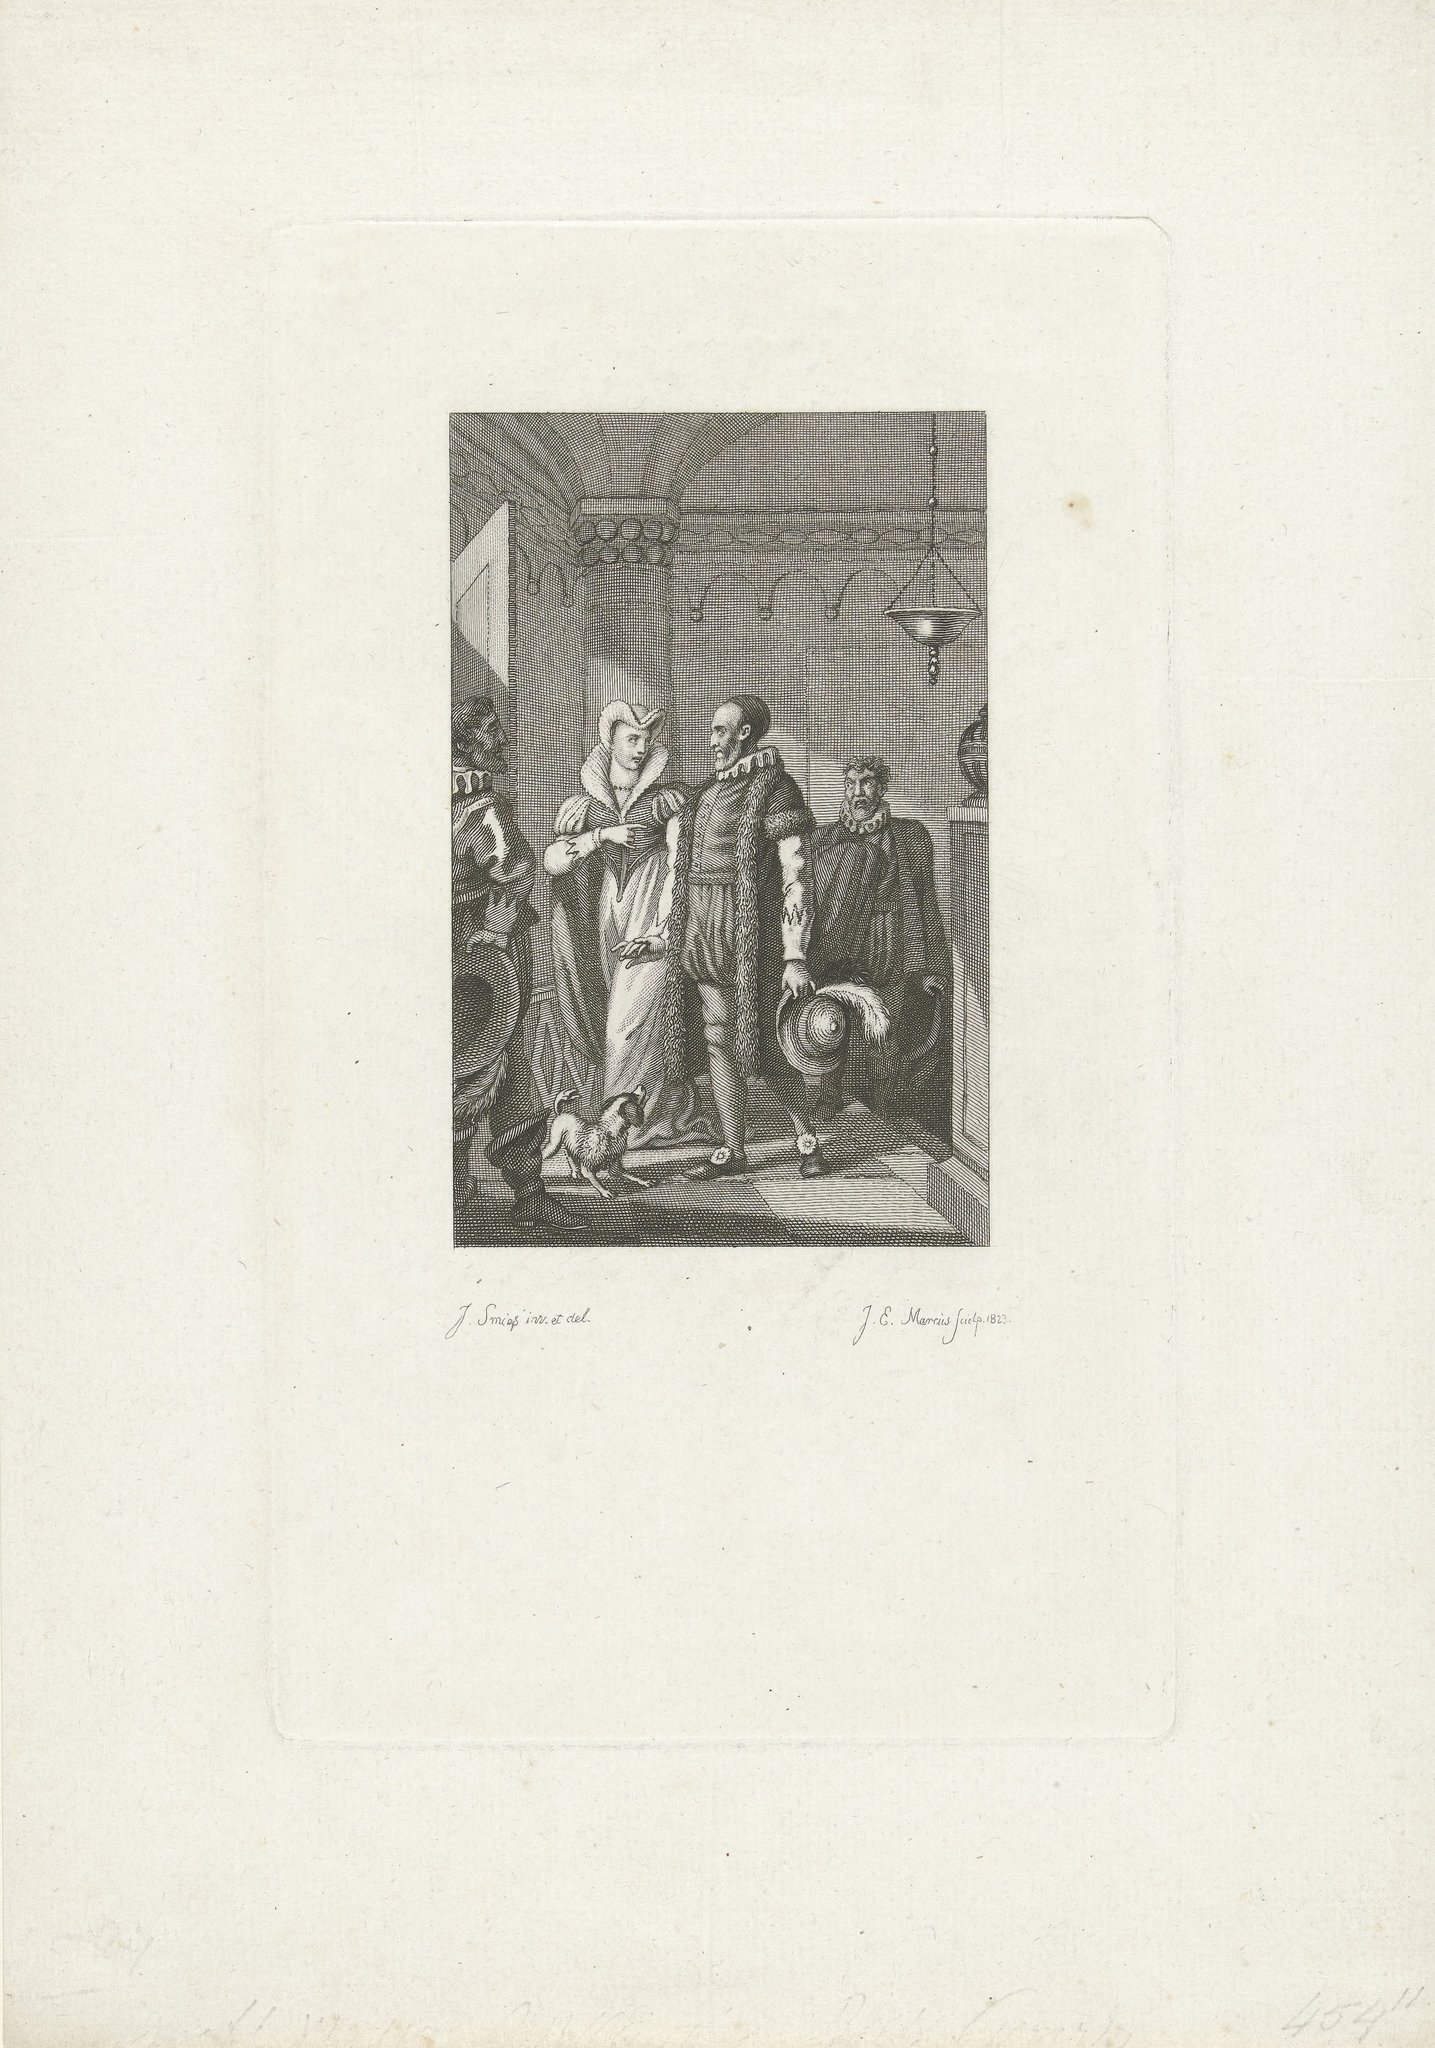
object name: print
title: Prins Willem loopt met echtgenote langs Balthasar Gerards, 1584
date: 1823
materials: paper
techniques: etching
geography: netherlands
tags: louise de coligny, delft, william i (prince of orange), attempt, political murder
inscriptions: date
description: Illustratie voor: P.C. Hoofts Nederlandsche historien / met aanteekn. en ophelderingen van M. Siegenbeek, A. Simons en J.P. van Cappelle. J. van der Hey, Amsterdam 1820-1824.